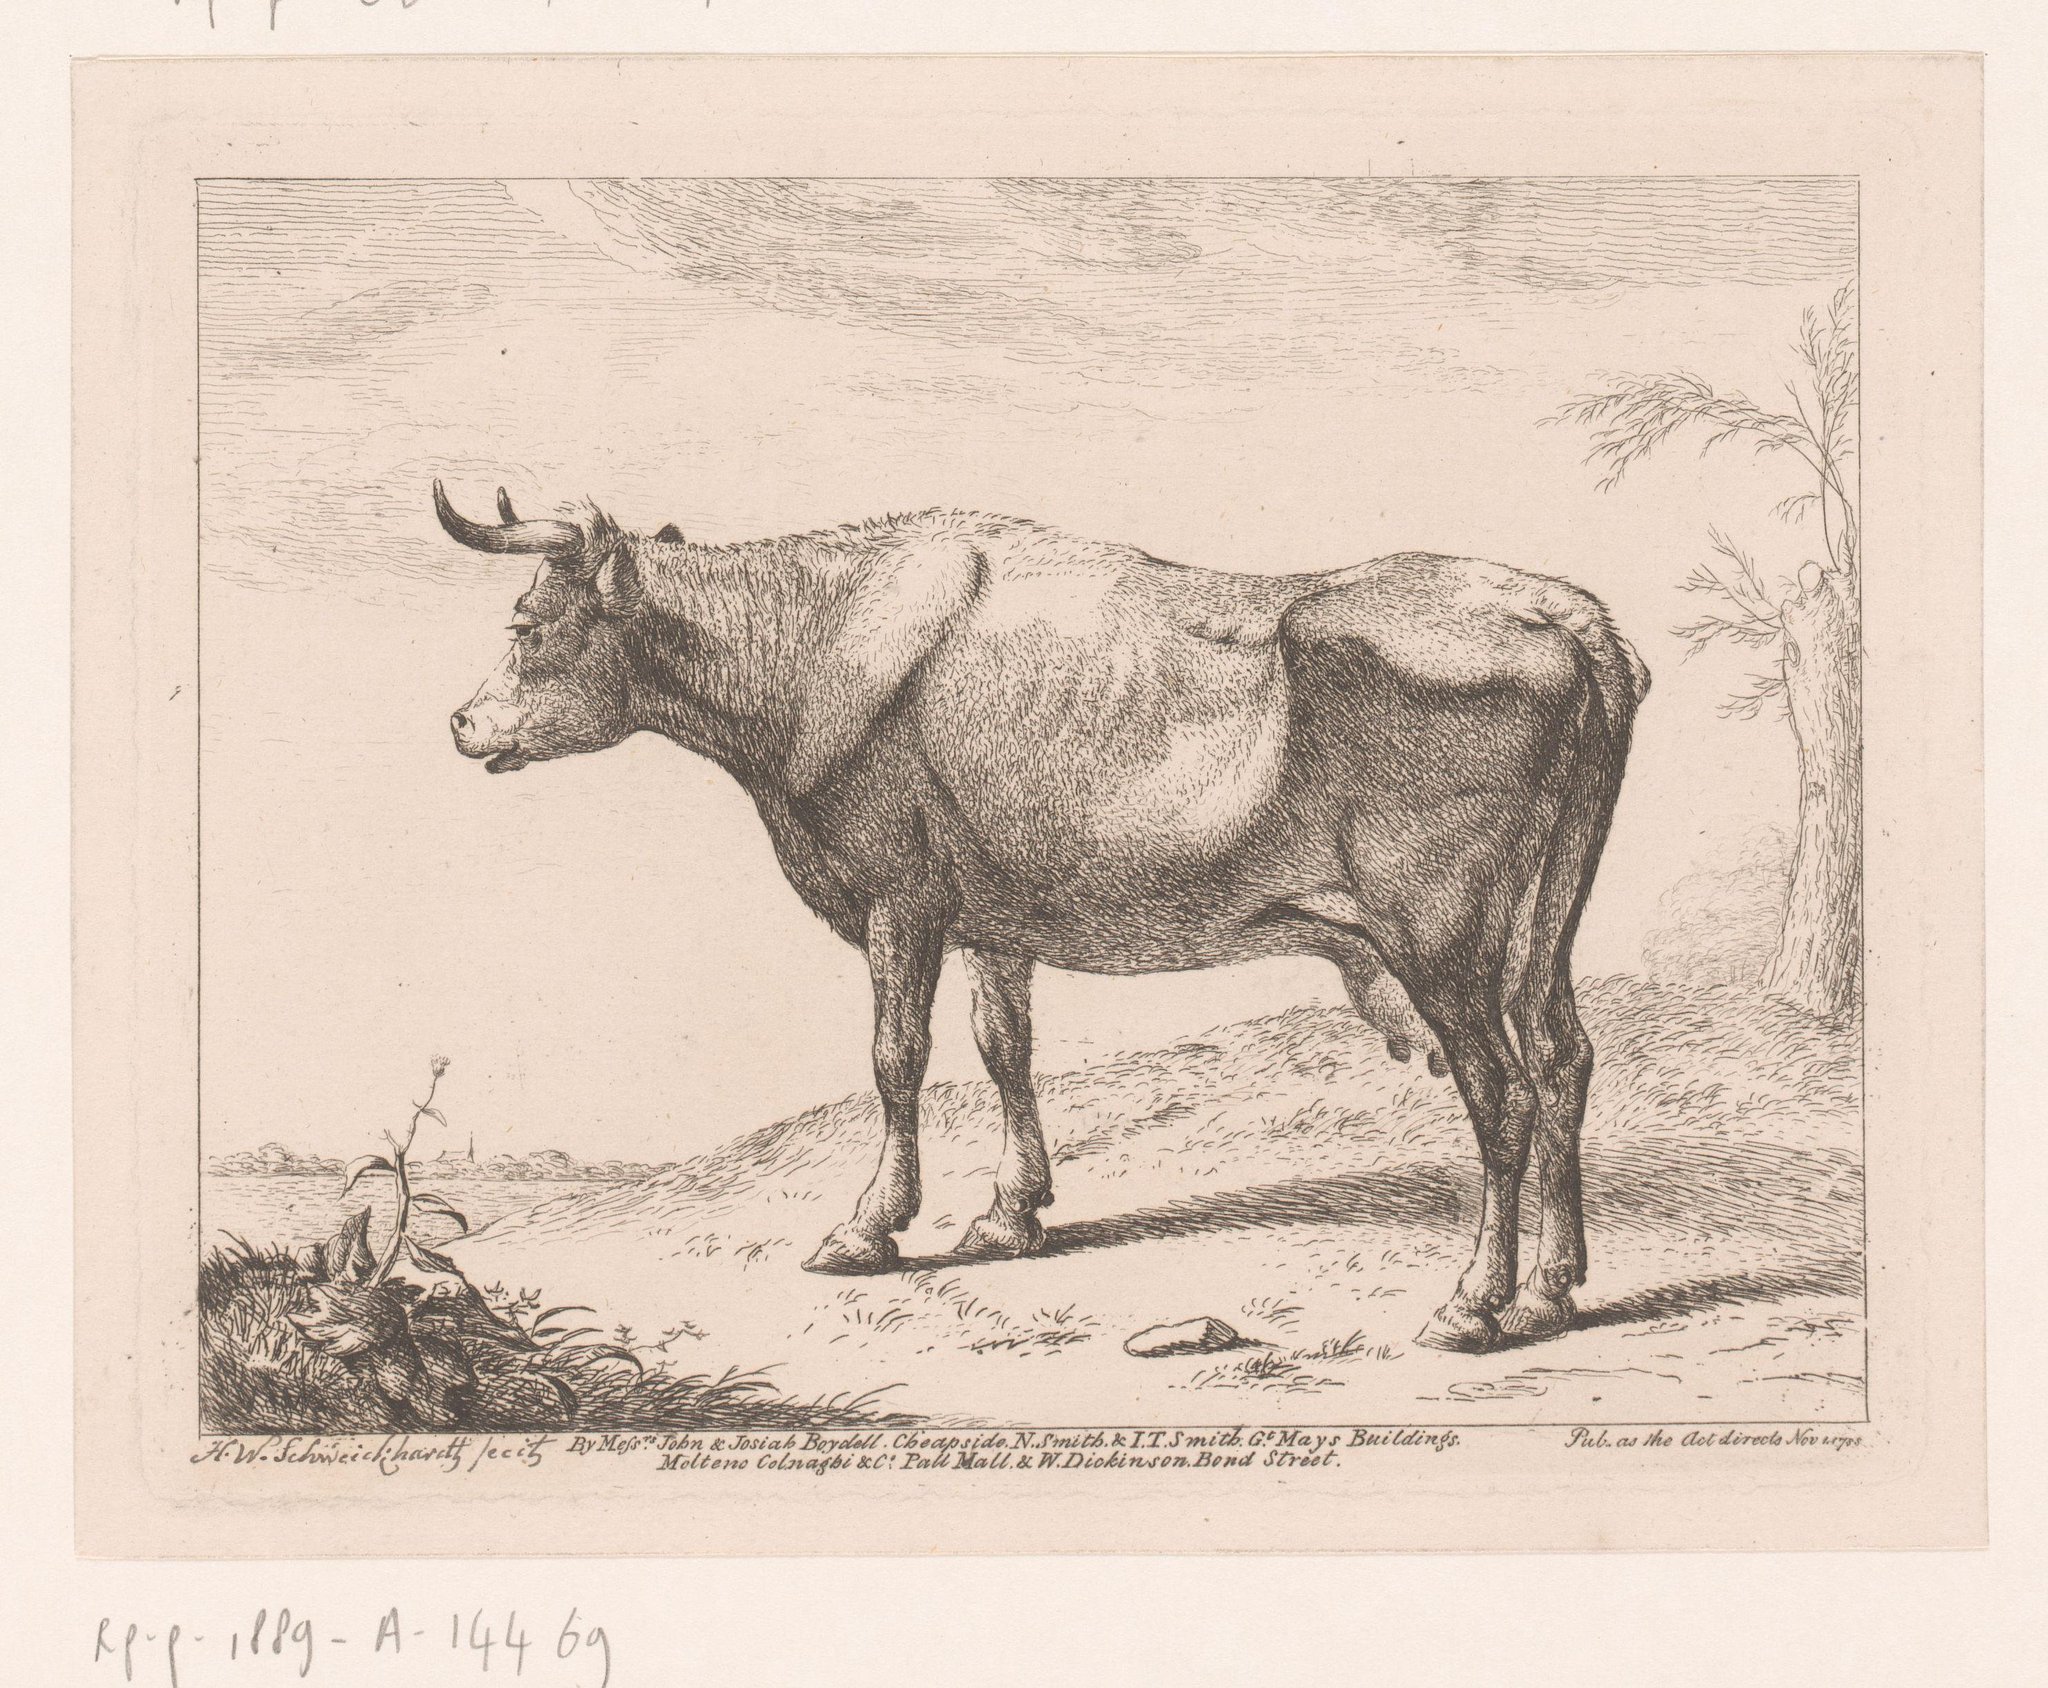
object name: print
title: Koe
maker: hendrik willem schweickhardt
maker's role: draughtsman, painter, print maker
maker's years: 1746-1797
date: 1788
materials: paper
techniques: etching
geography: england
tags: cow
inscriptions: name: ‘H.W. Scheickhardt fecit’, collector's mark: Lugt 2228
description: Behoort tot een serie van acht prenten met verschillende dieren.